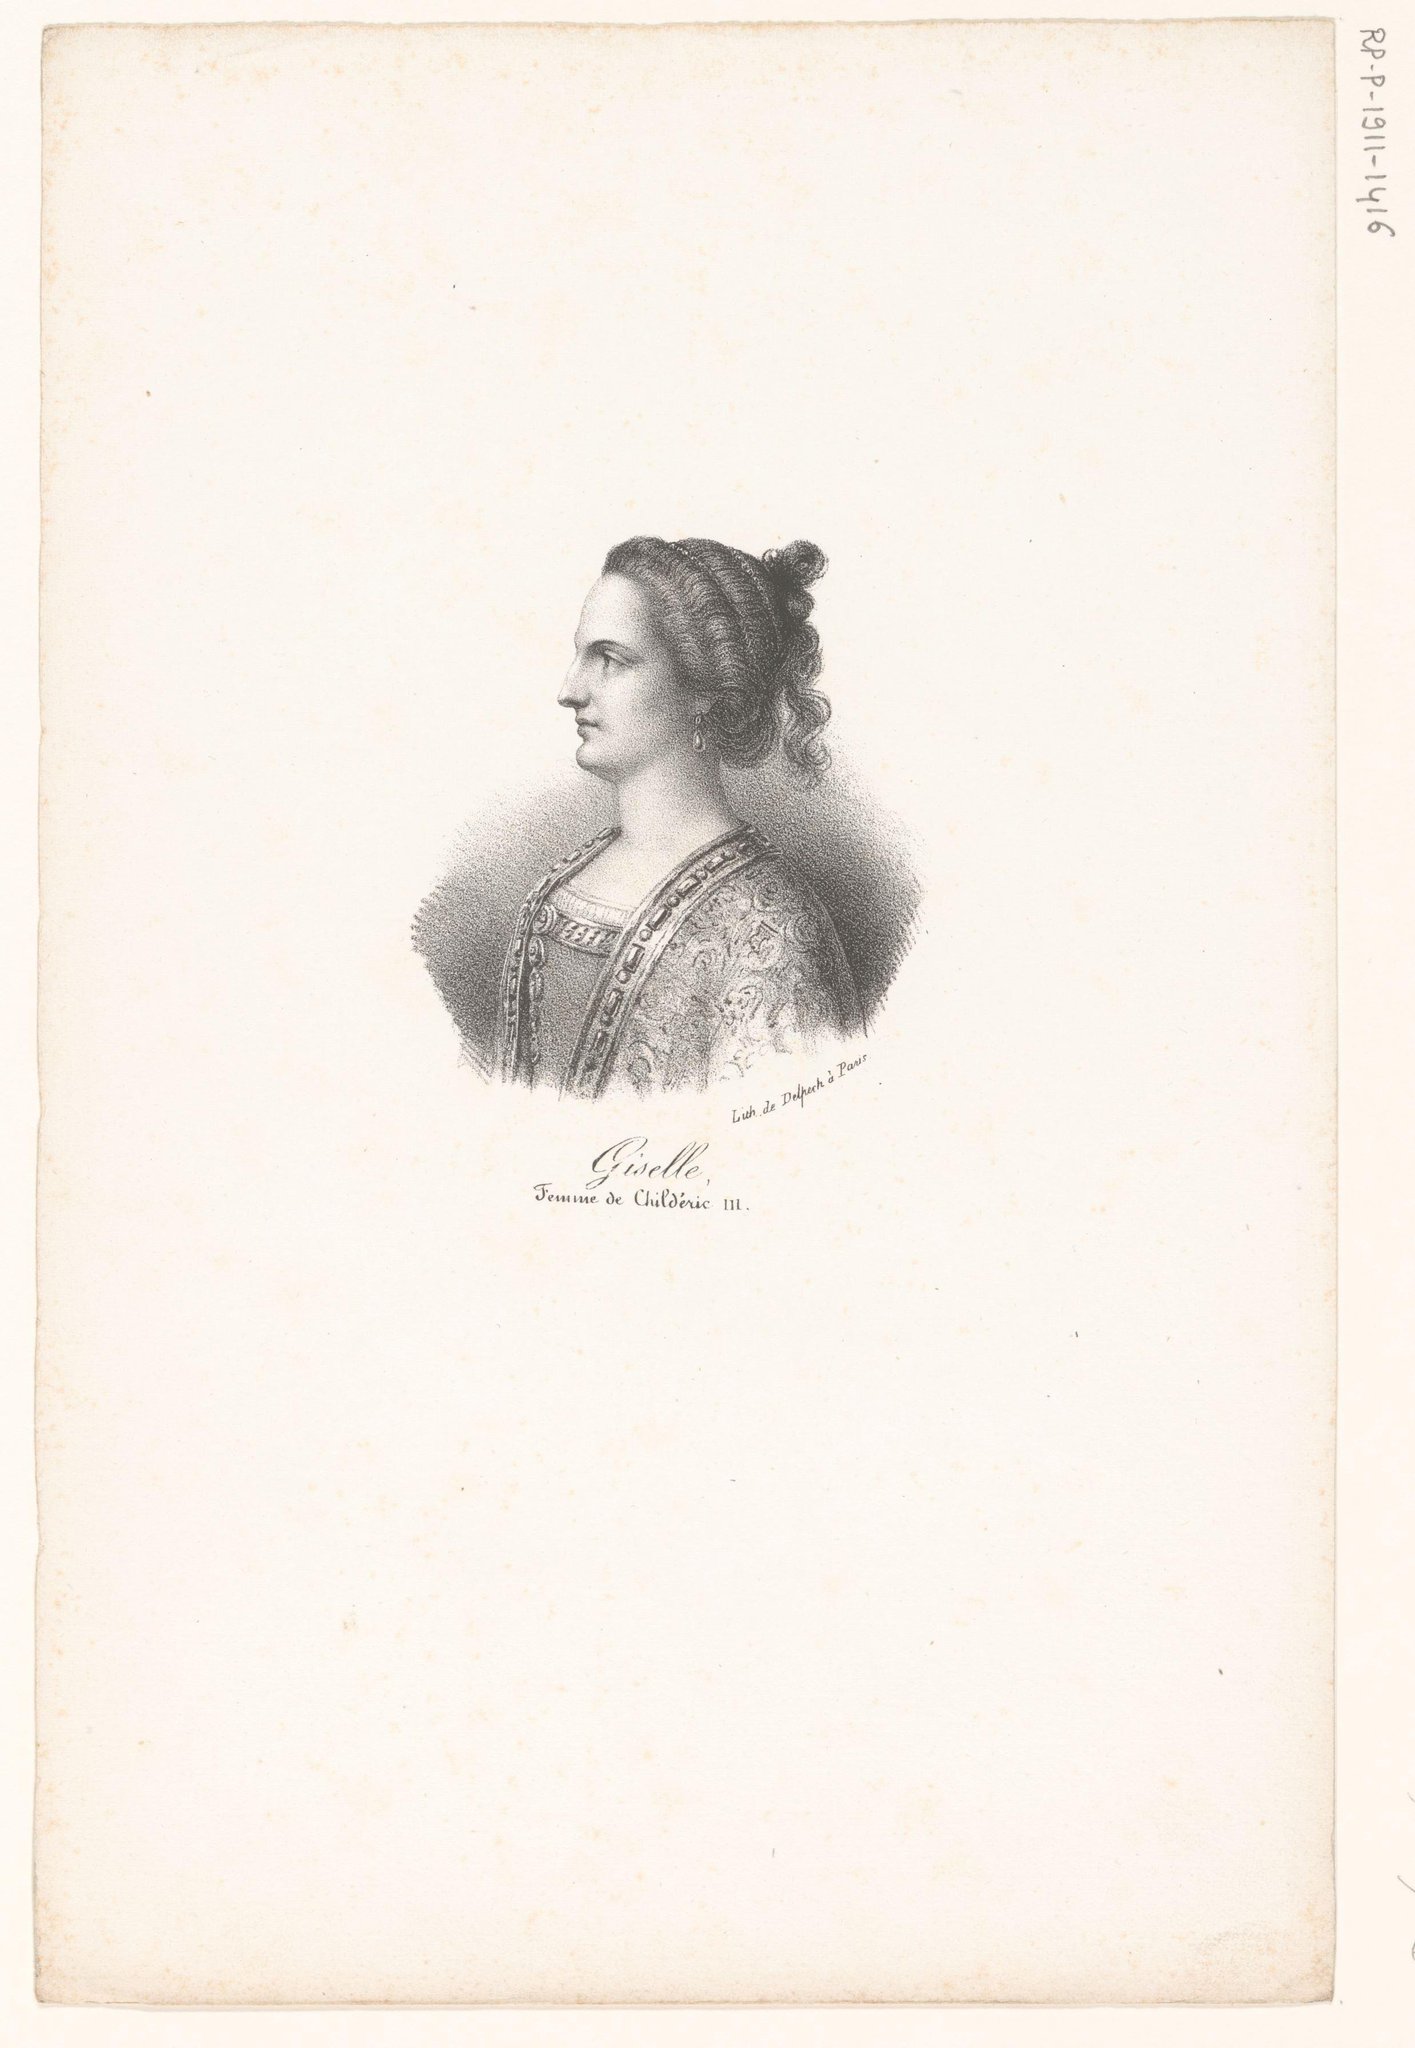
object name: print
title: Portret van koningin Giselle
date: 1818-1842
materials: paper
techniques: lithograph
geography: paris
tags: historical persons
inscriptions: collector's mark: Lugt 2228a